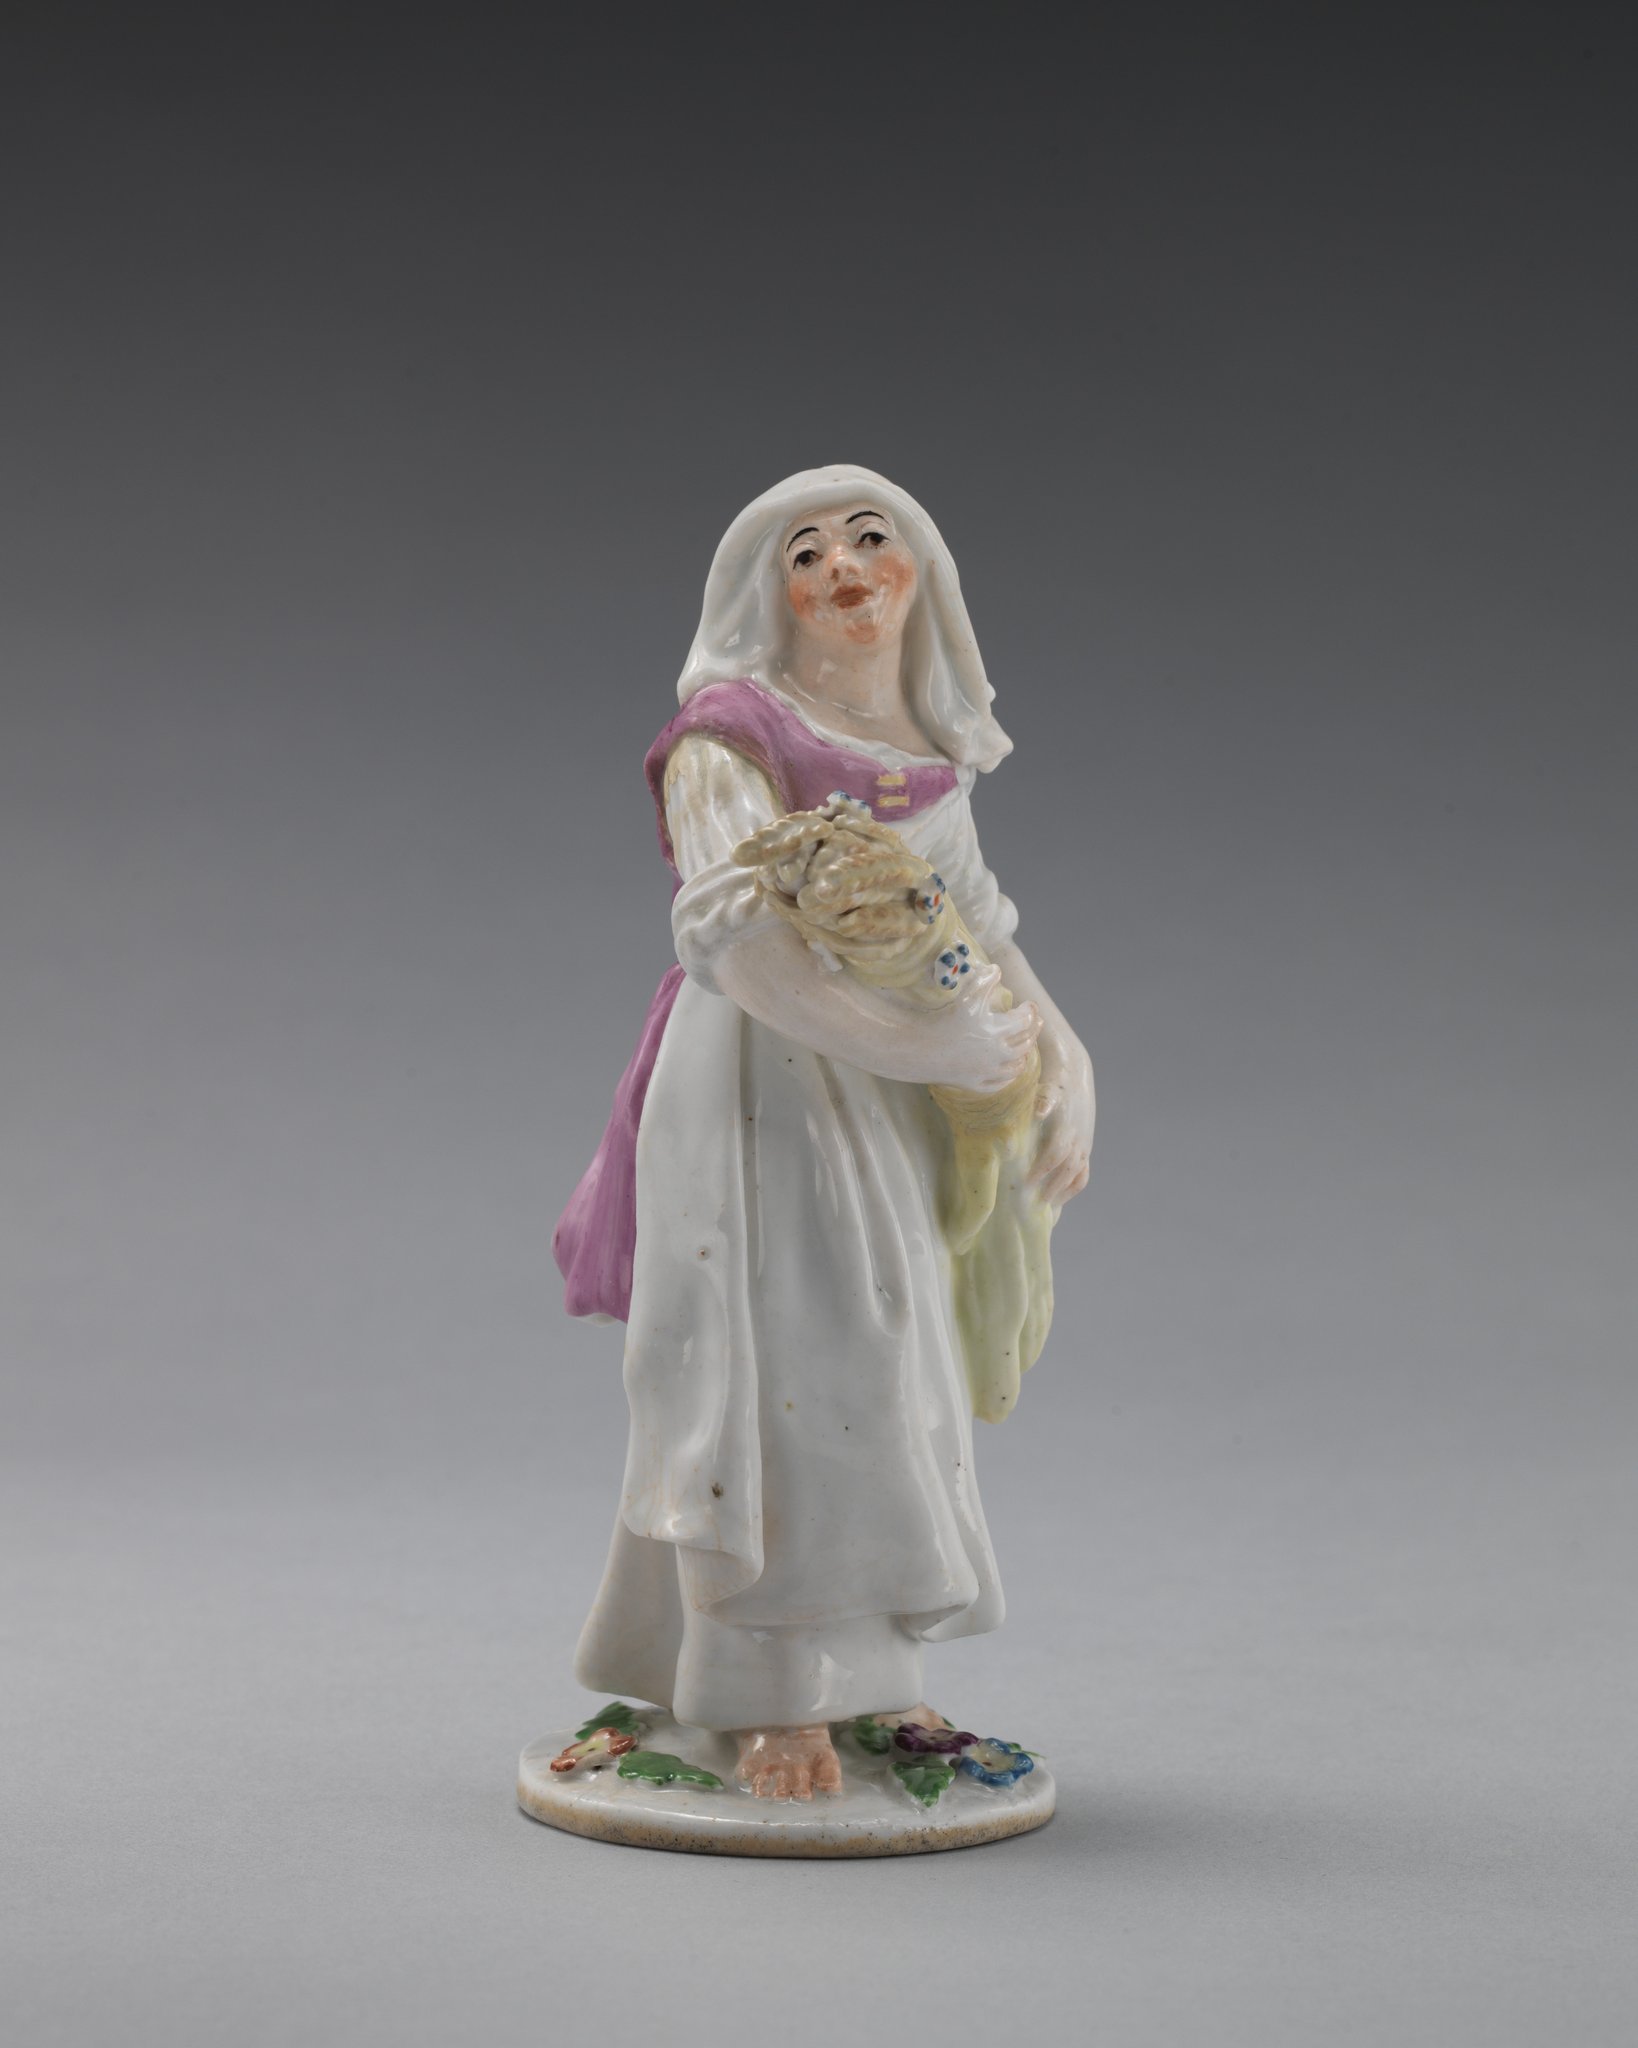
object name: figure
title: Four Seasons (Summer)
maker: chelsea porcelain manufactory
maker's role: factory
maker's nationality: british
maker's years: 1744-1784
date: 1753-1755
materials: soft paste porcelain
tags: women